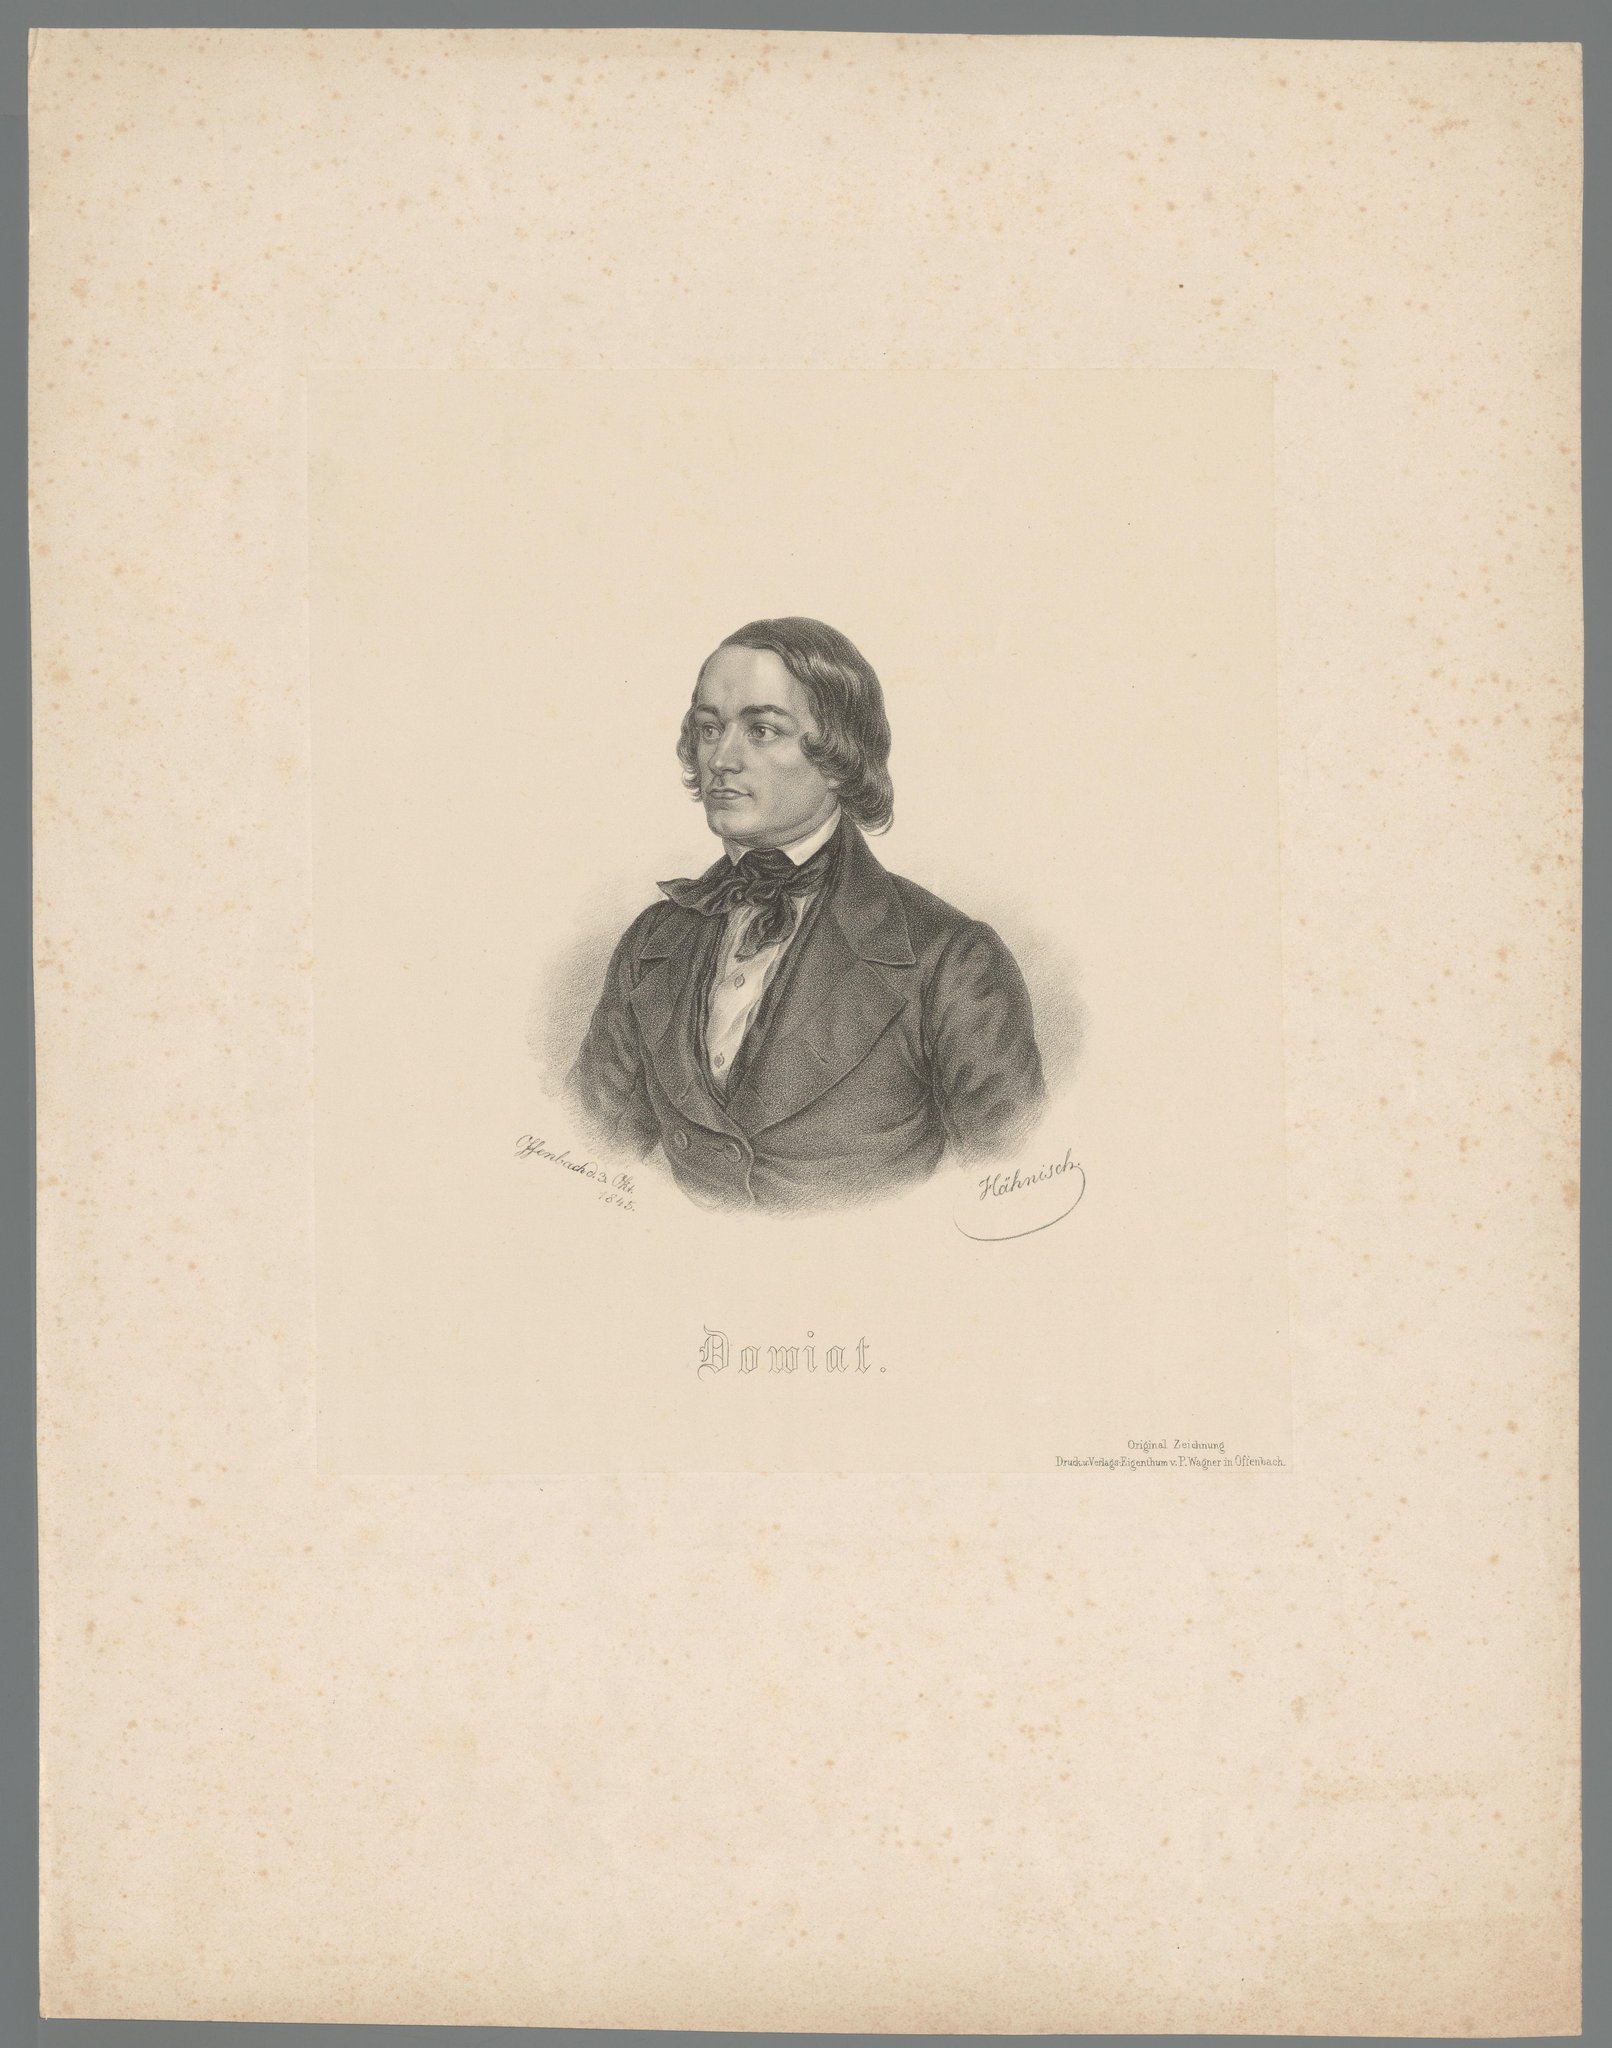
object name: print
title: Portret van R. Dowiat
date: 1845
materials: paper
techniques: lithograph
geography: offenbach am main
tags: adult man, historical persons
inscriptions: collector's mark: Lugt 2228